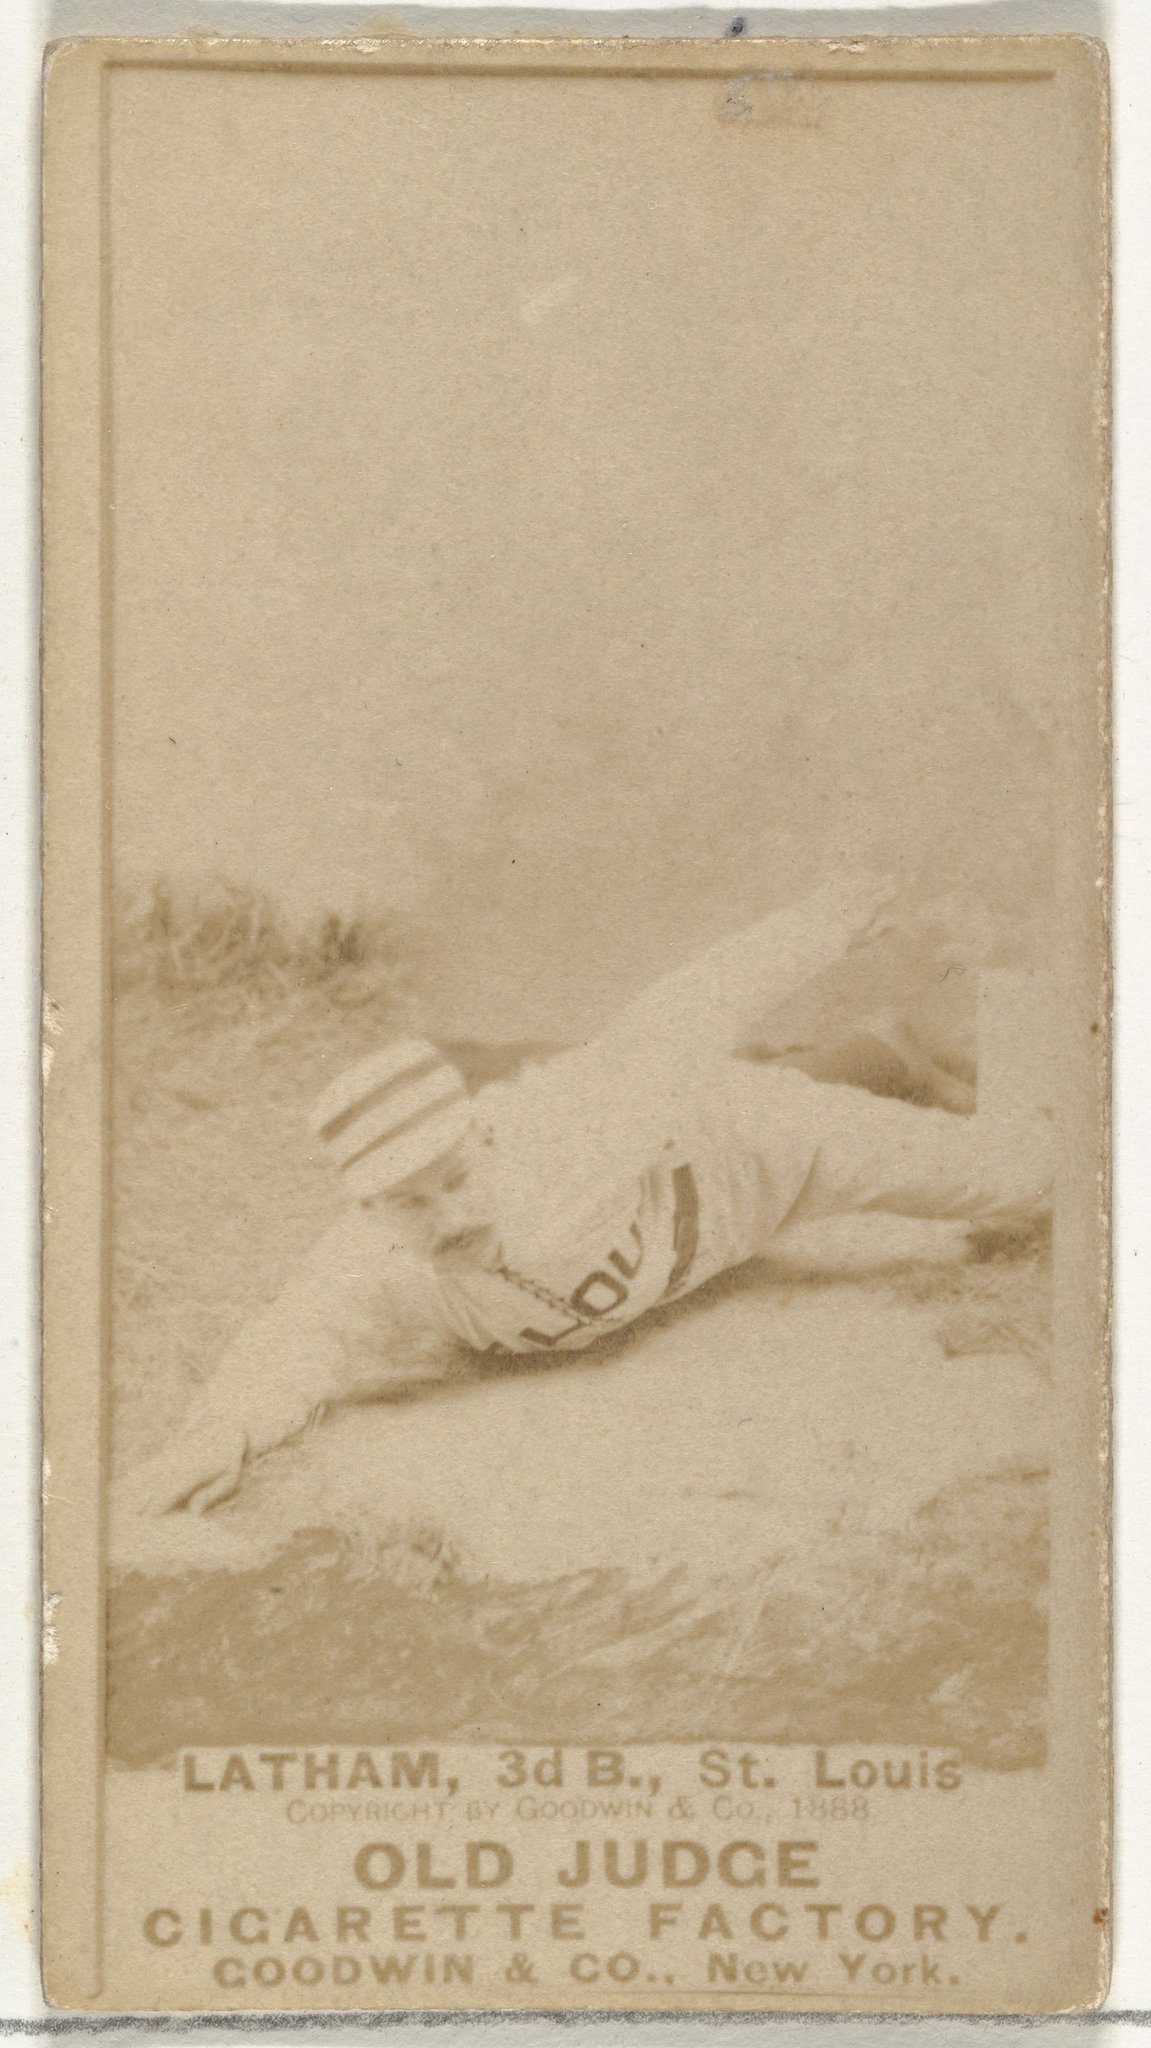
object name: baseball card, photograph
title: Arlie Latham, 3rd Base, St. Louis Browns, from the Old Judge series (N172) for Old Judge Cigarettes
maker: goodwin & company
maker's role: publisher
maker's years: 1850-1950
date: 1888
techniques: albumen silver print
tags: men,portraits,baseball,athletes